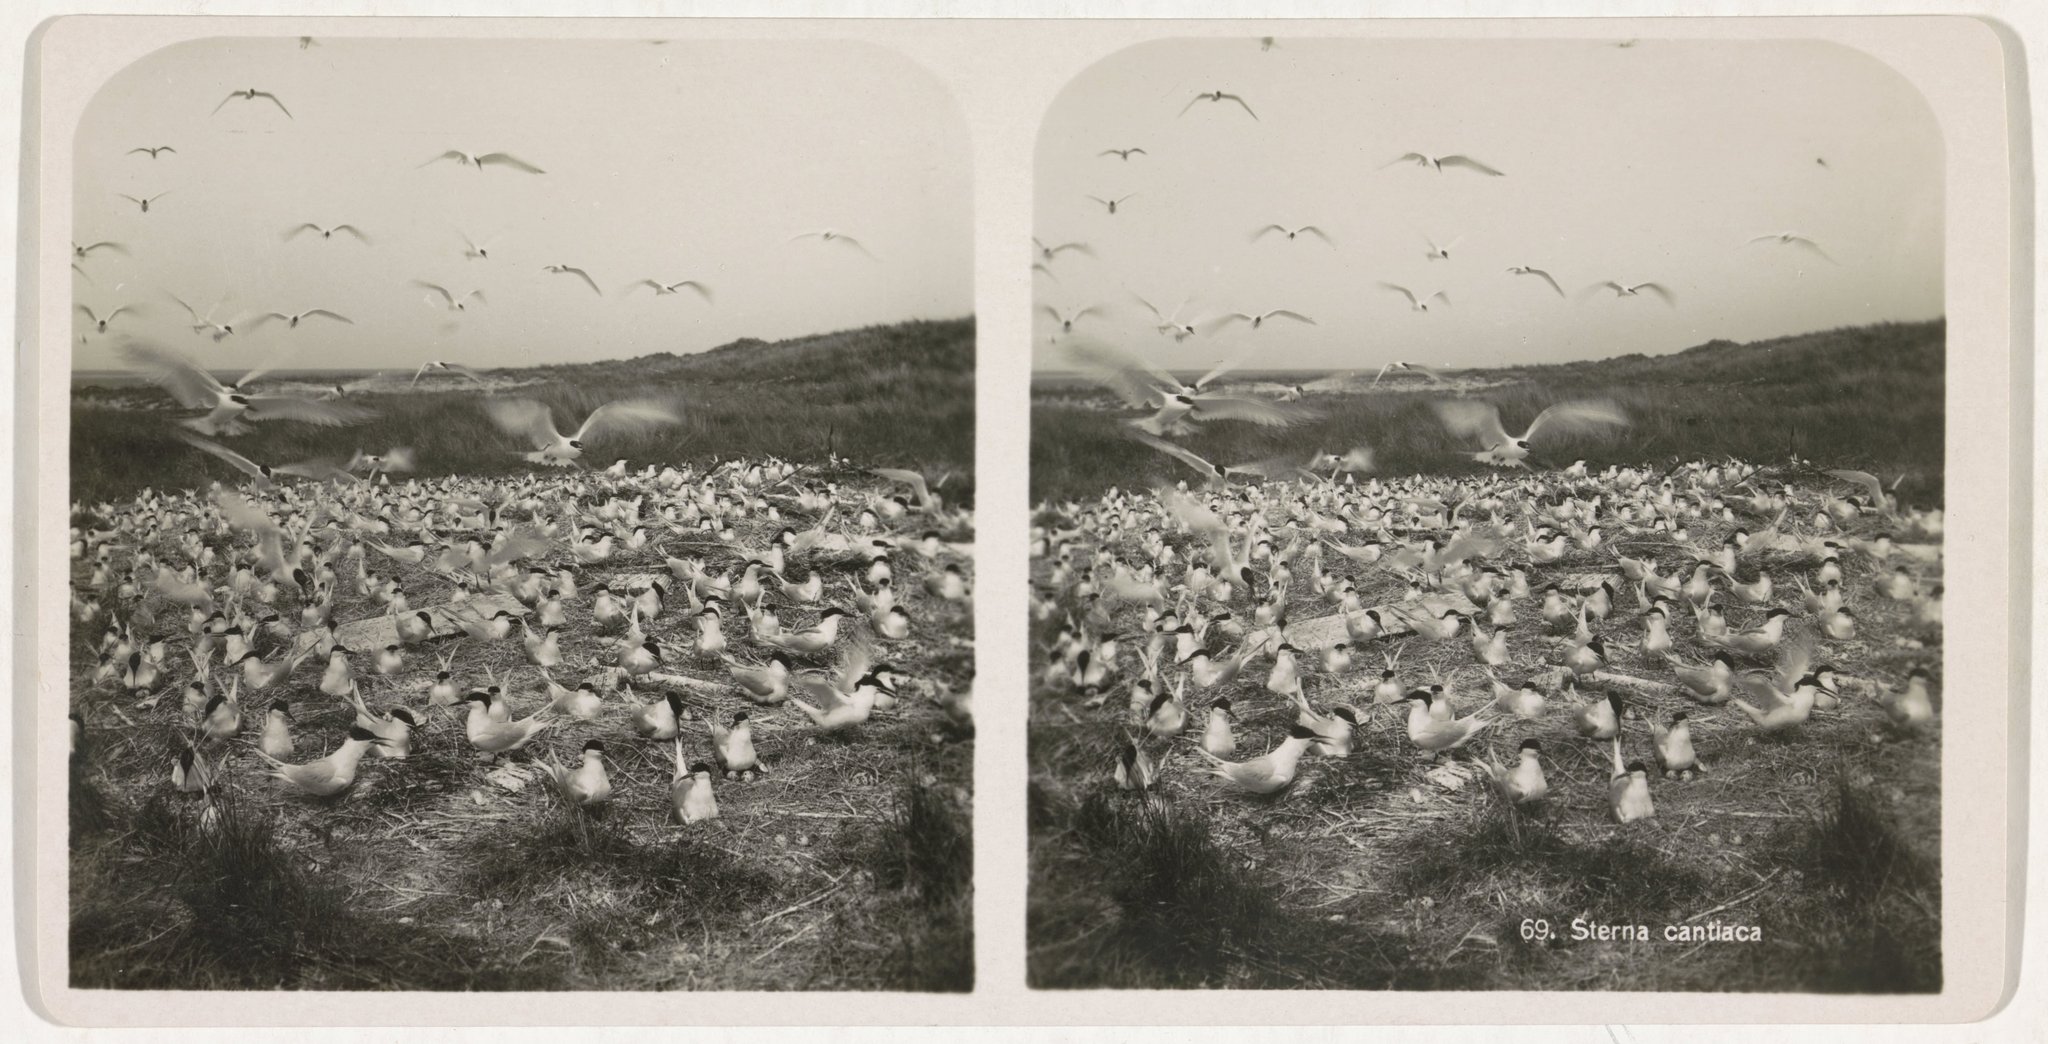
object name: stereograph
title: Onze vogels in 't wild. / Zeevogels / Sterntjes en Meeuwen.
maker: adolphe burdet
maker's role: fotograaf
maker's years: 1860-1940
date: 1870-1940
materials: photographic support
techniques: gelatin silver print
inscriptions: label: ‘Zee Zwaluwen’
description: De foto maakt deel uit van een serie van 12 stereofoto's, bewaard in het originele mapje. De foto's tonen zeevogels in natuurgebied De Bol op Texel.